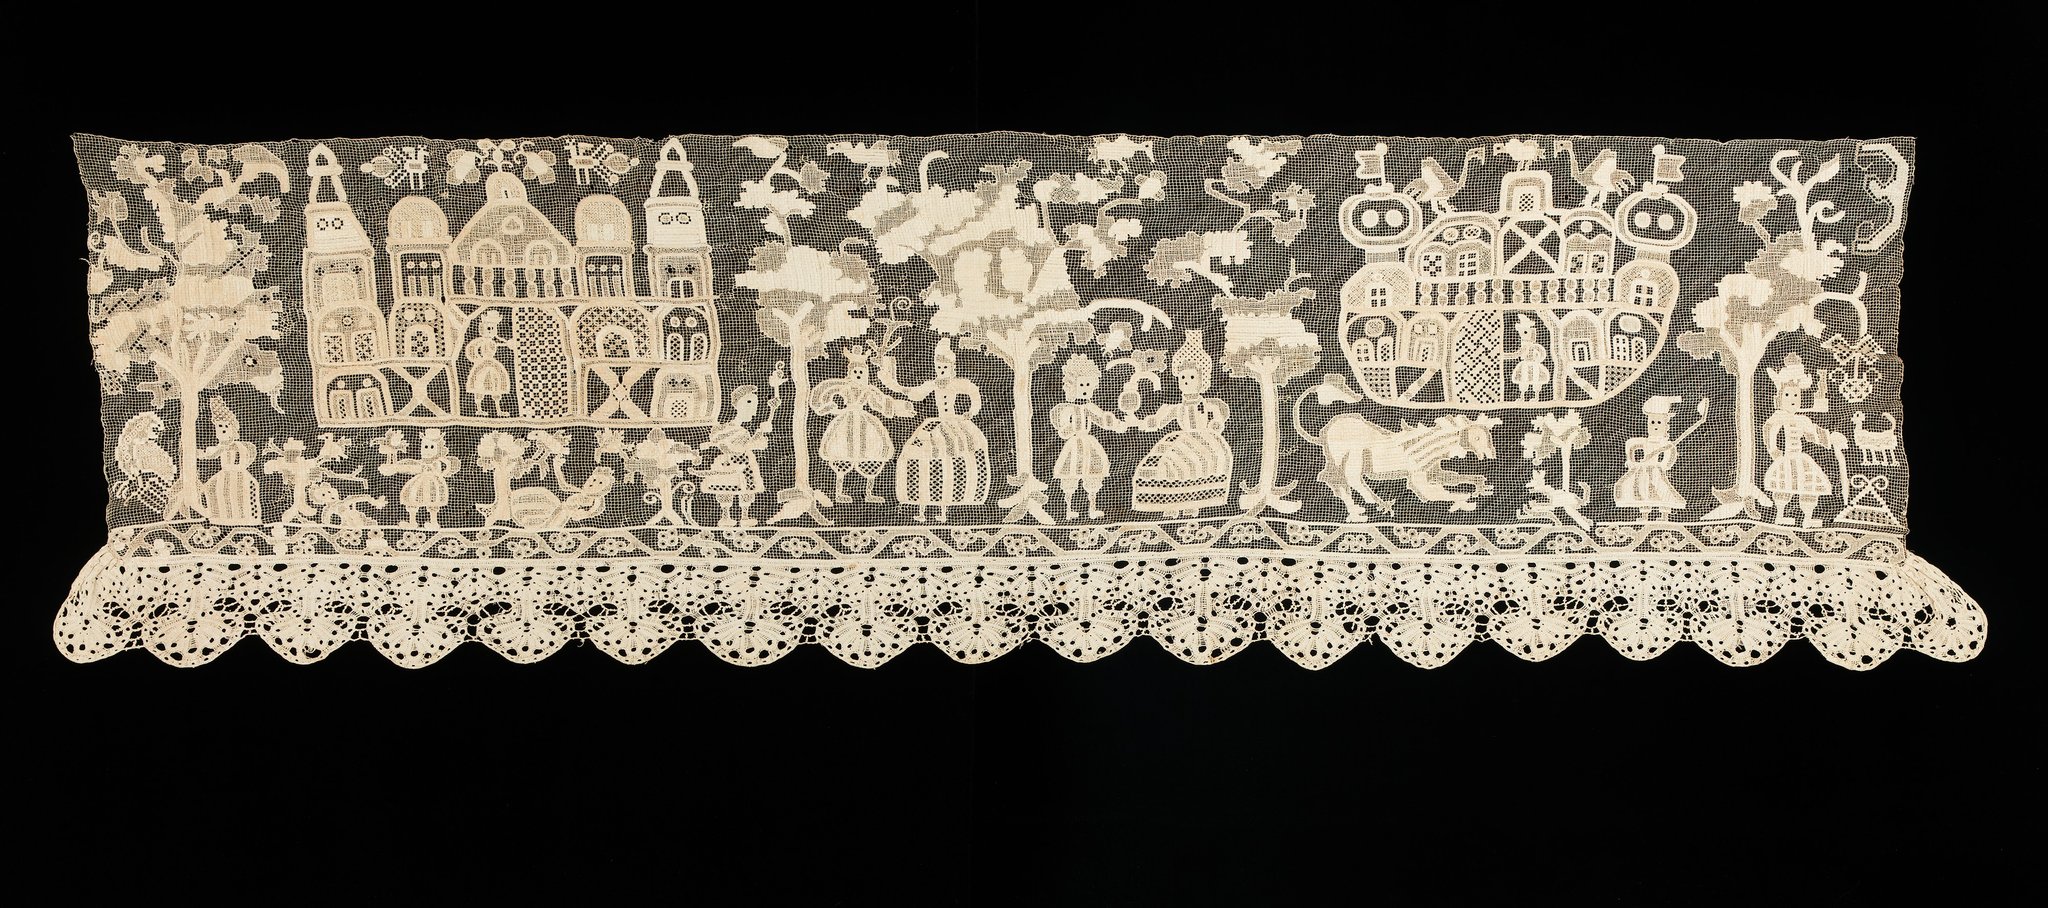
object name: border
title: Bed curtain border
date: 1801-1825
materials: linen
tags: animals,men,women,trees